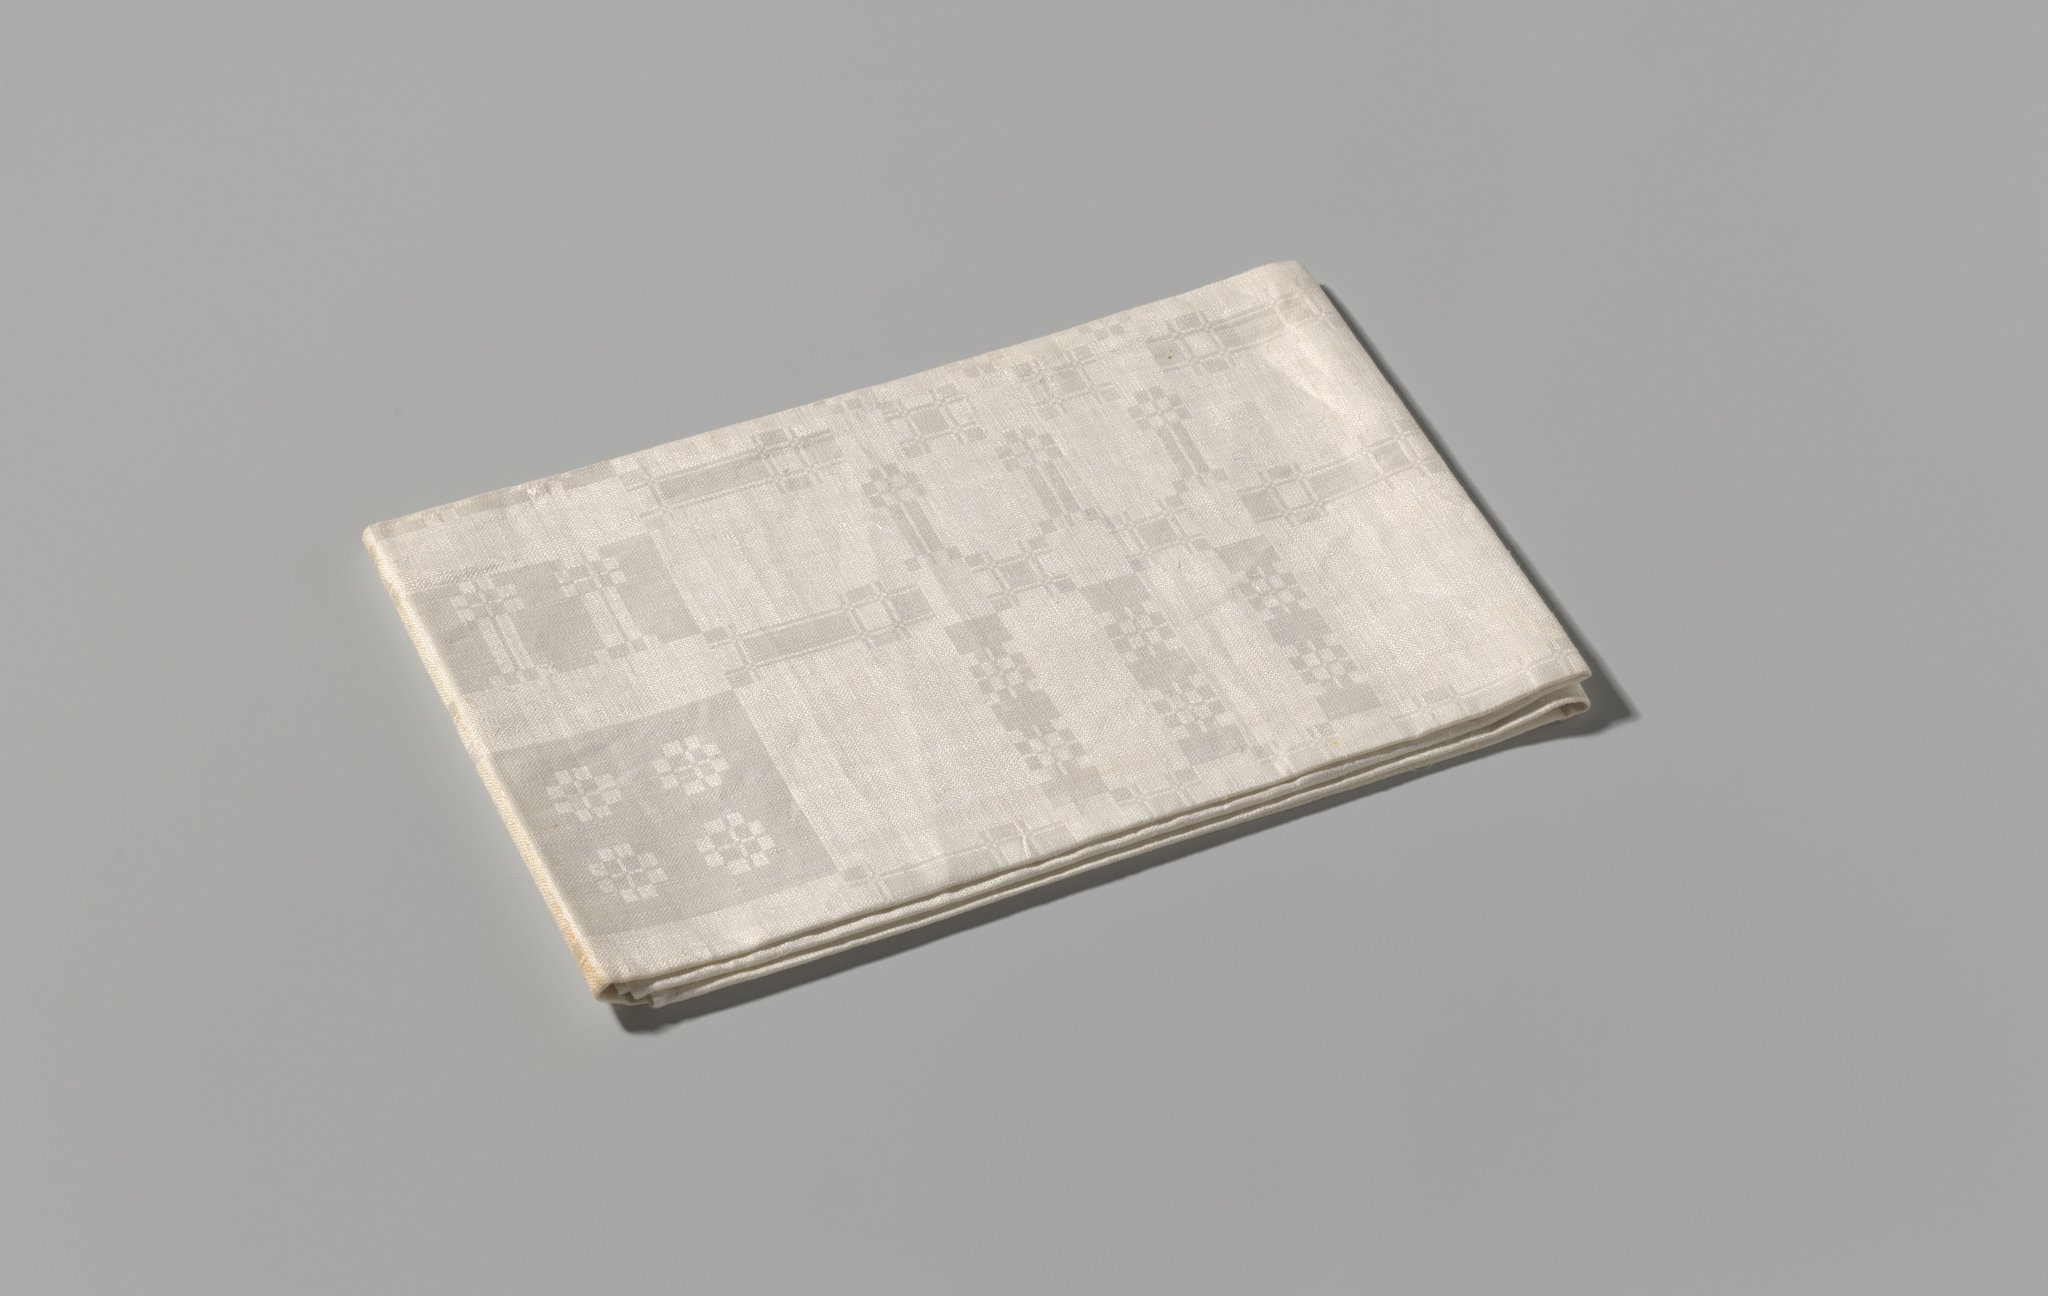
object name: handdwaal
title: Handdoek van wit linnen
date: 1780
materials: linen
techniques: peeled fabric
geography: northern netherlands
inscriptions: date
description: Wit linnen handdwaal, pellen in kruiskeper, gemerkt WS 7 en 1780.